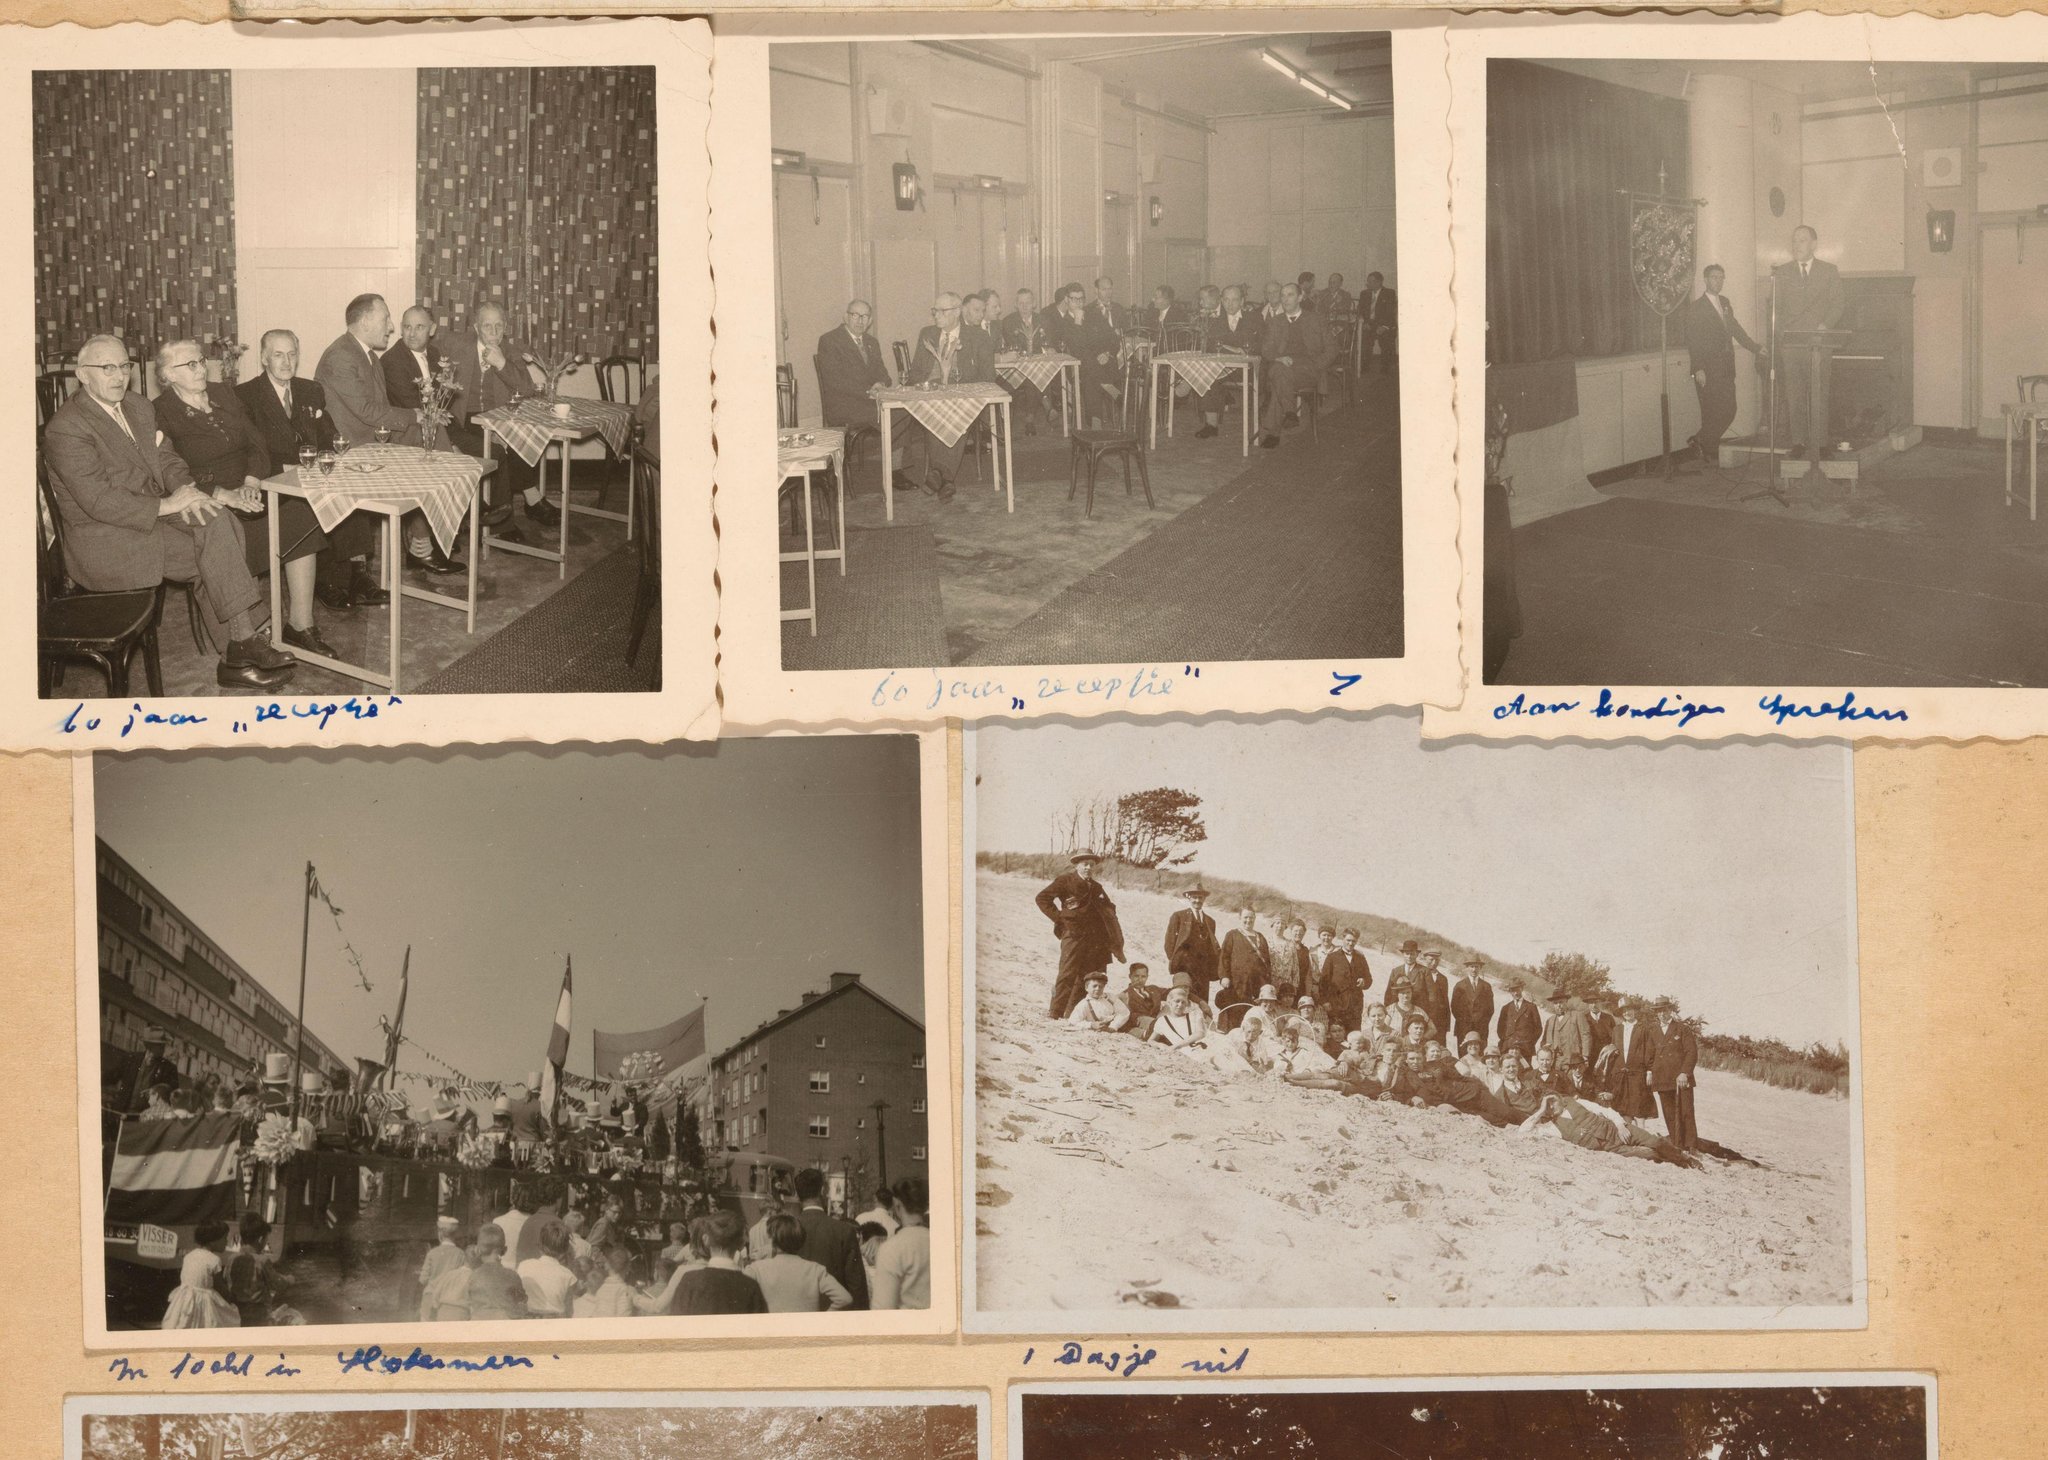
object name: photograph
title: 1 Dagje uit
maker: Anonymous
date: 1930-1950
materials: cardboard, photographic support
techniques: gelatin silver print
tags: forest, wood